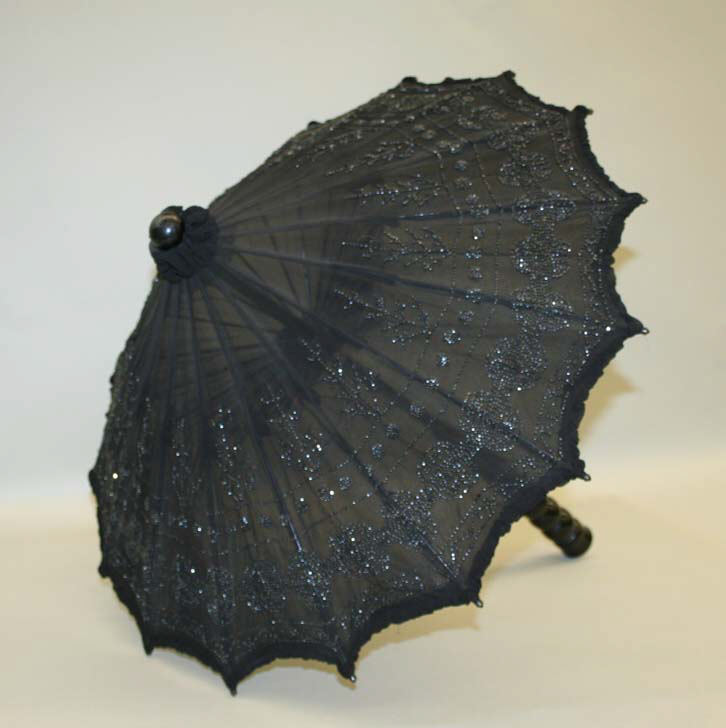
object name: parasol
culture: american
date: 1885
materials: metal, silk, wood